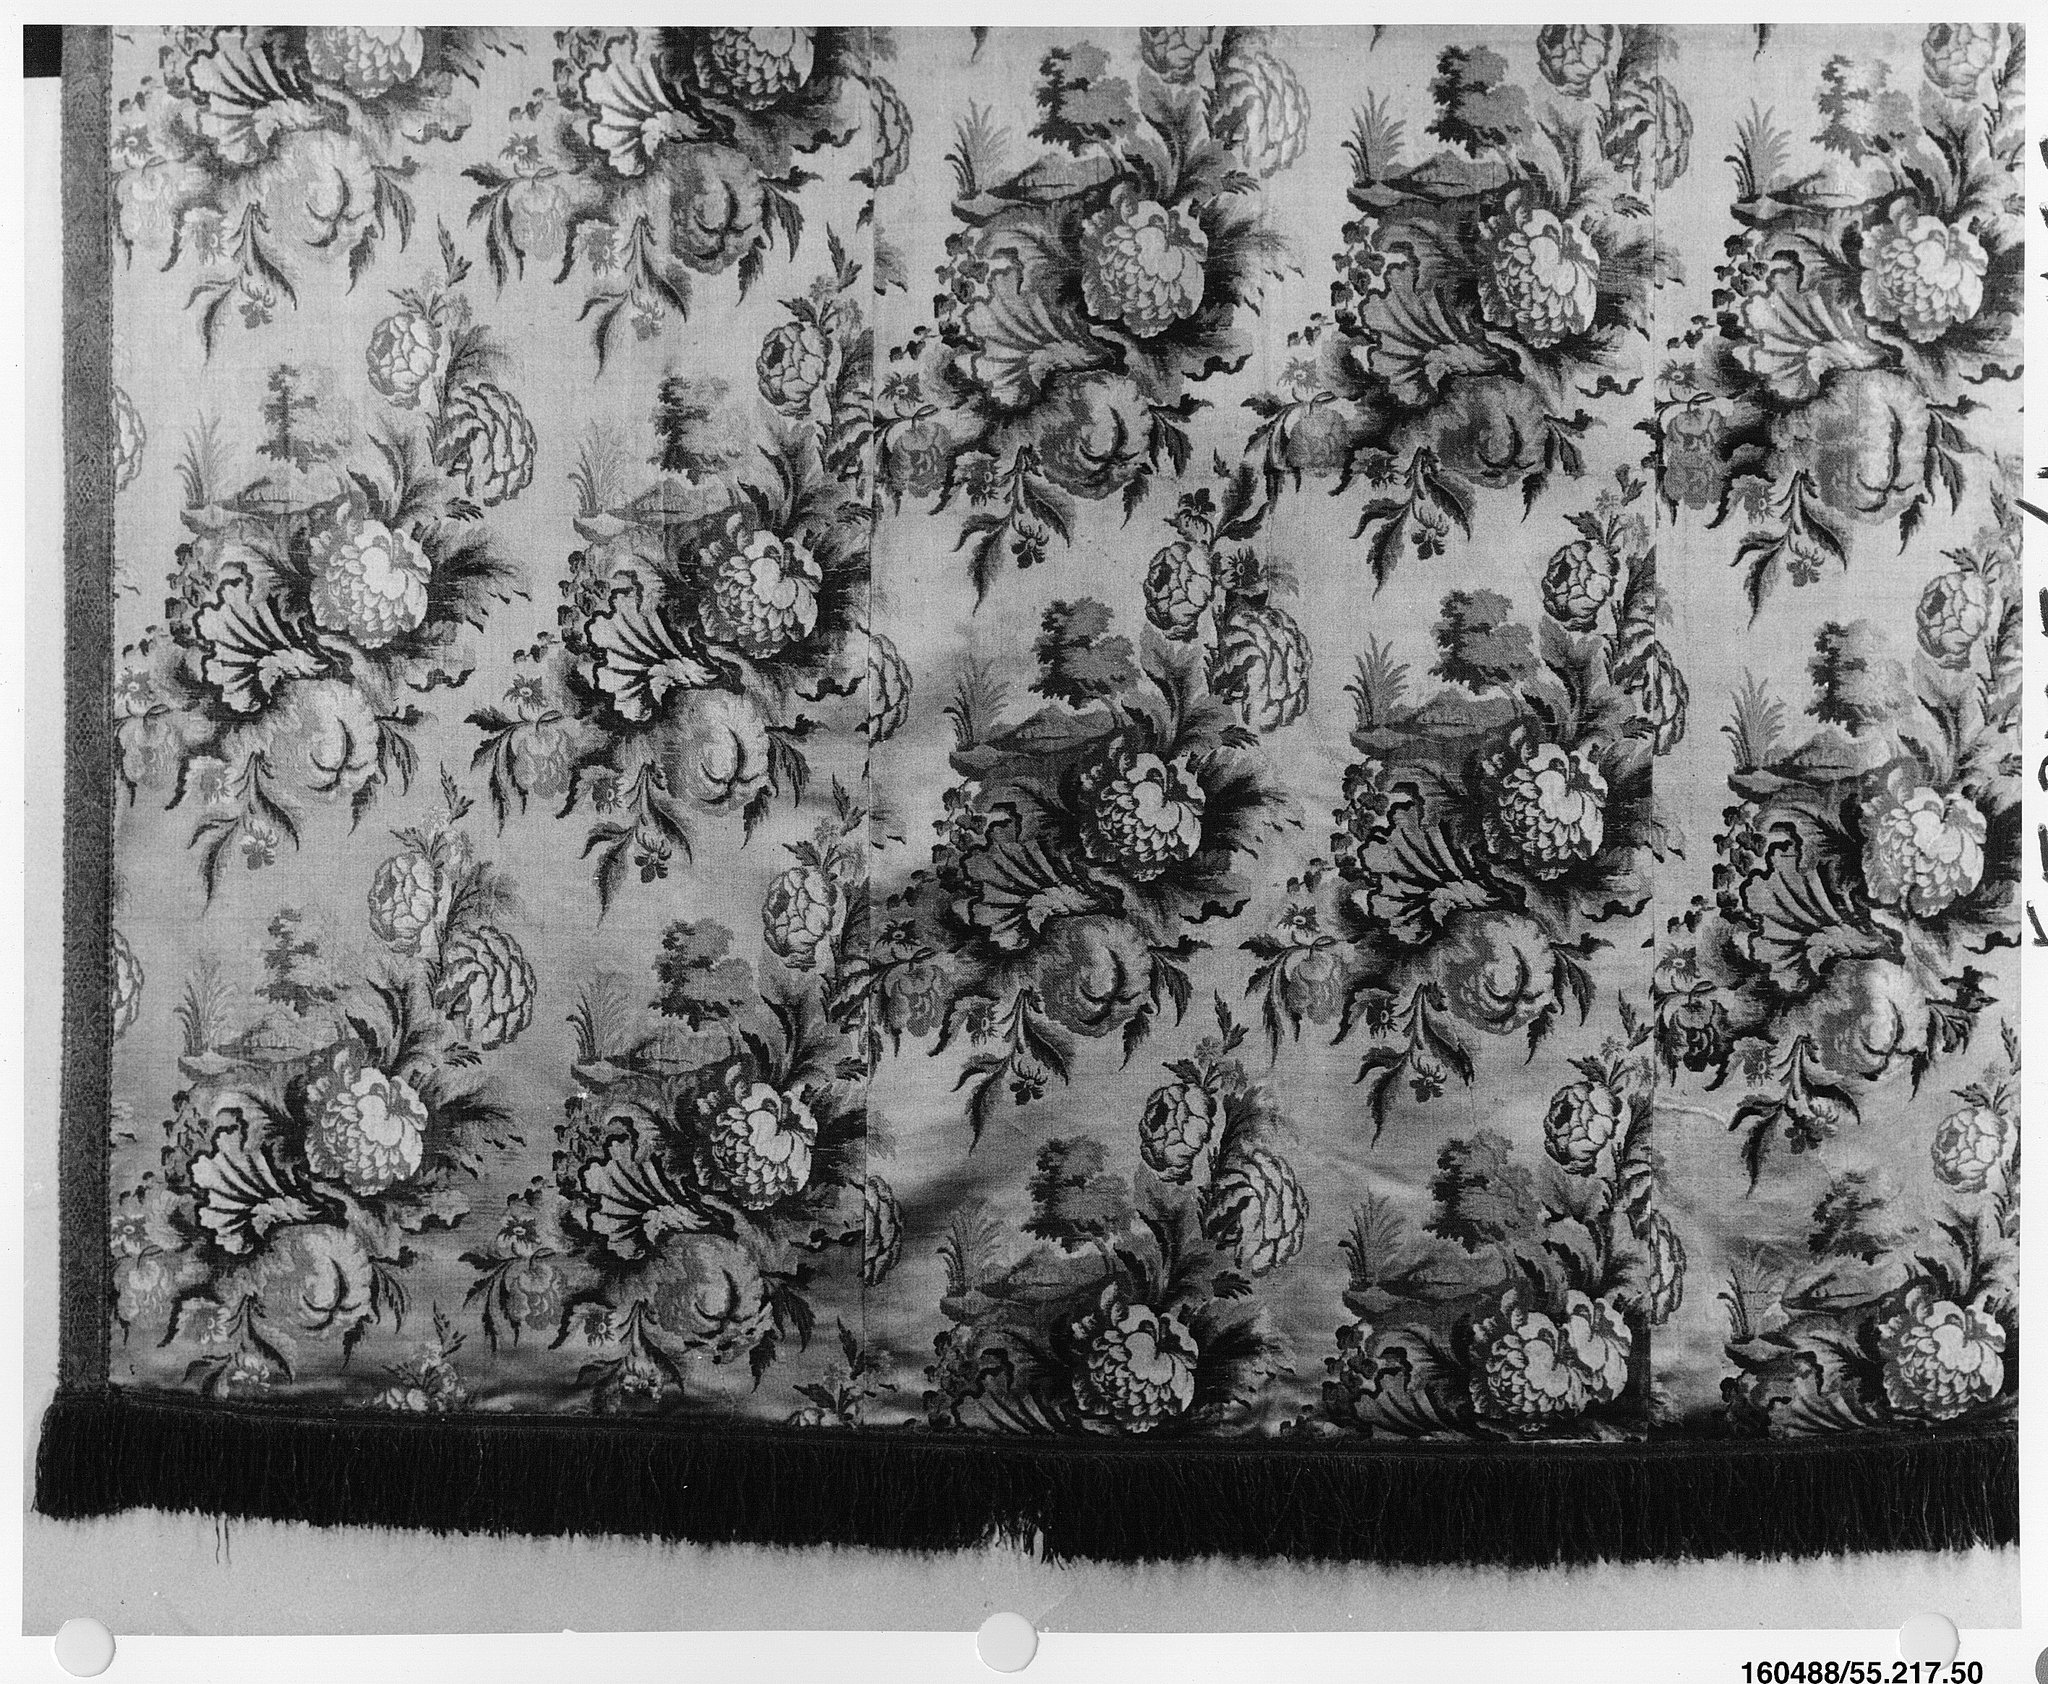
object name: piece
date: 1735-1740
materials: silk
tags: flowers,leaves